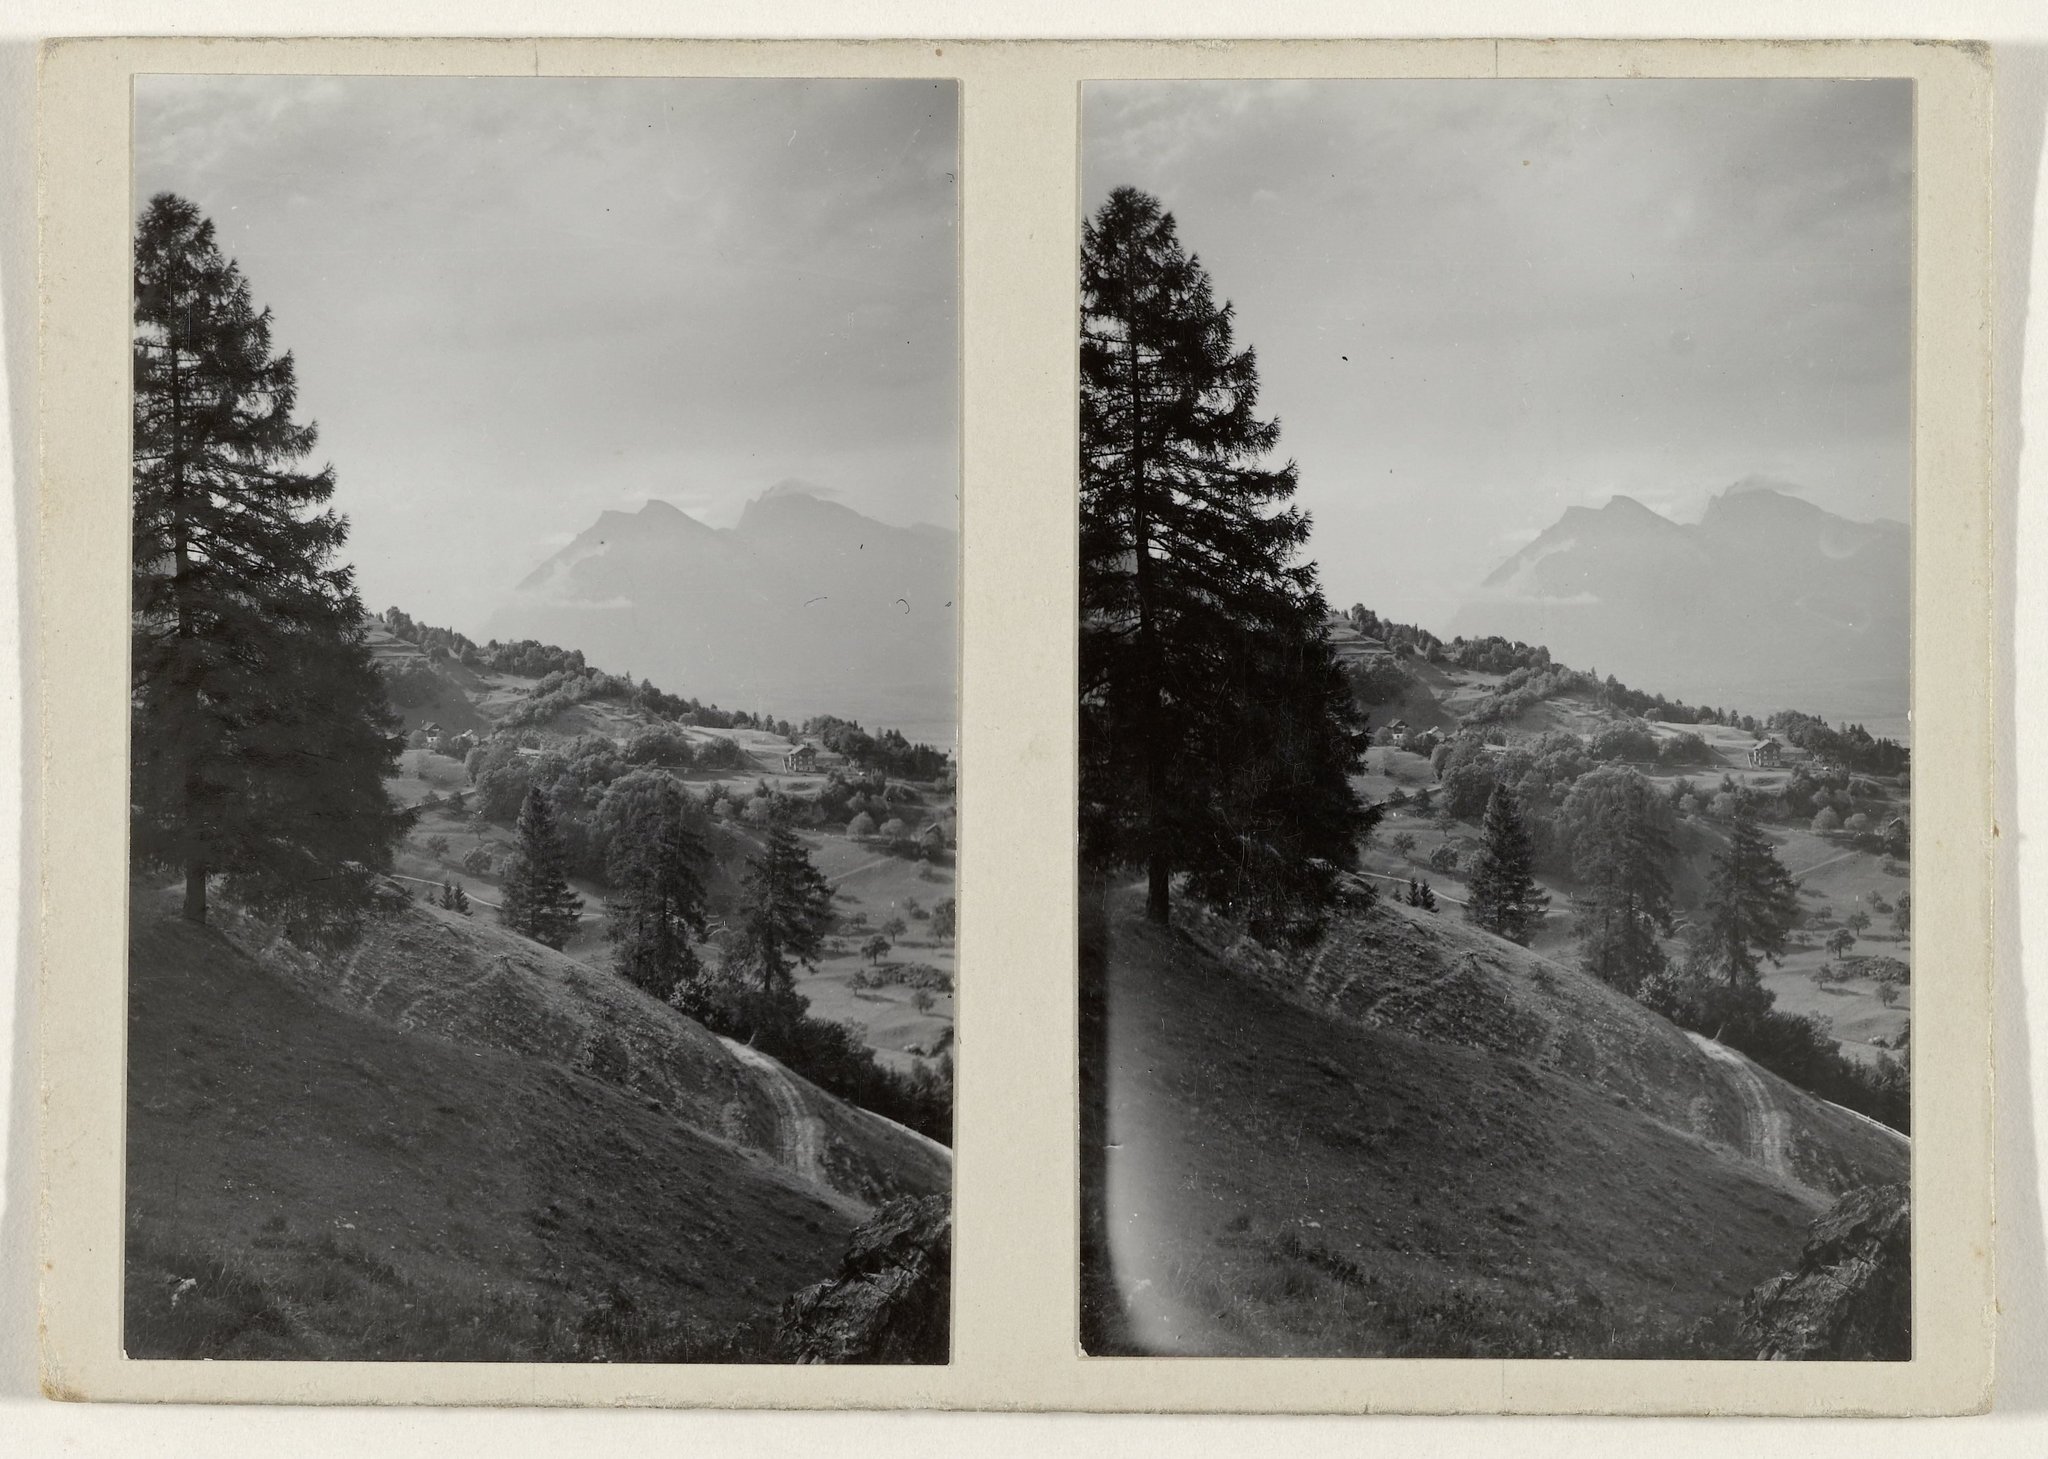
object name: stereograph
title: Bomen in een berglandschap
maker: geldolph adriaan kessler (dolph)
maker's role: fotograaf, industrieel, voetballer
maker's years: 1884-1945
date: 1920-1945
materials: paper, photographic support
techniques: collodion silver print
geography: netherlands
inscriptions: title: ‘Bomen Ragaz’